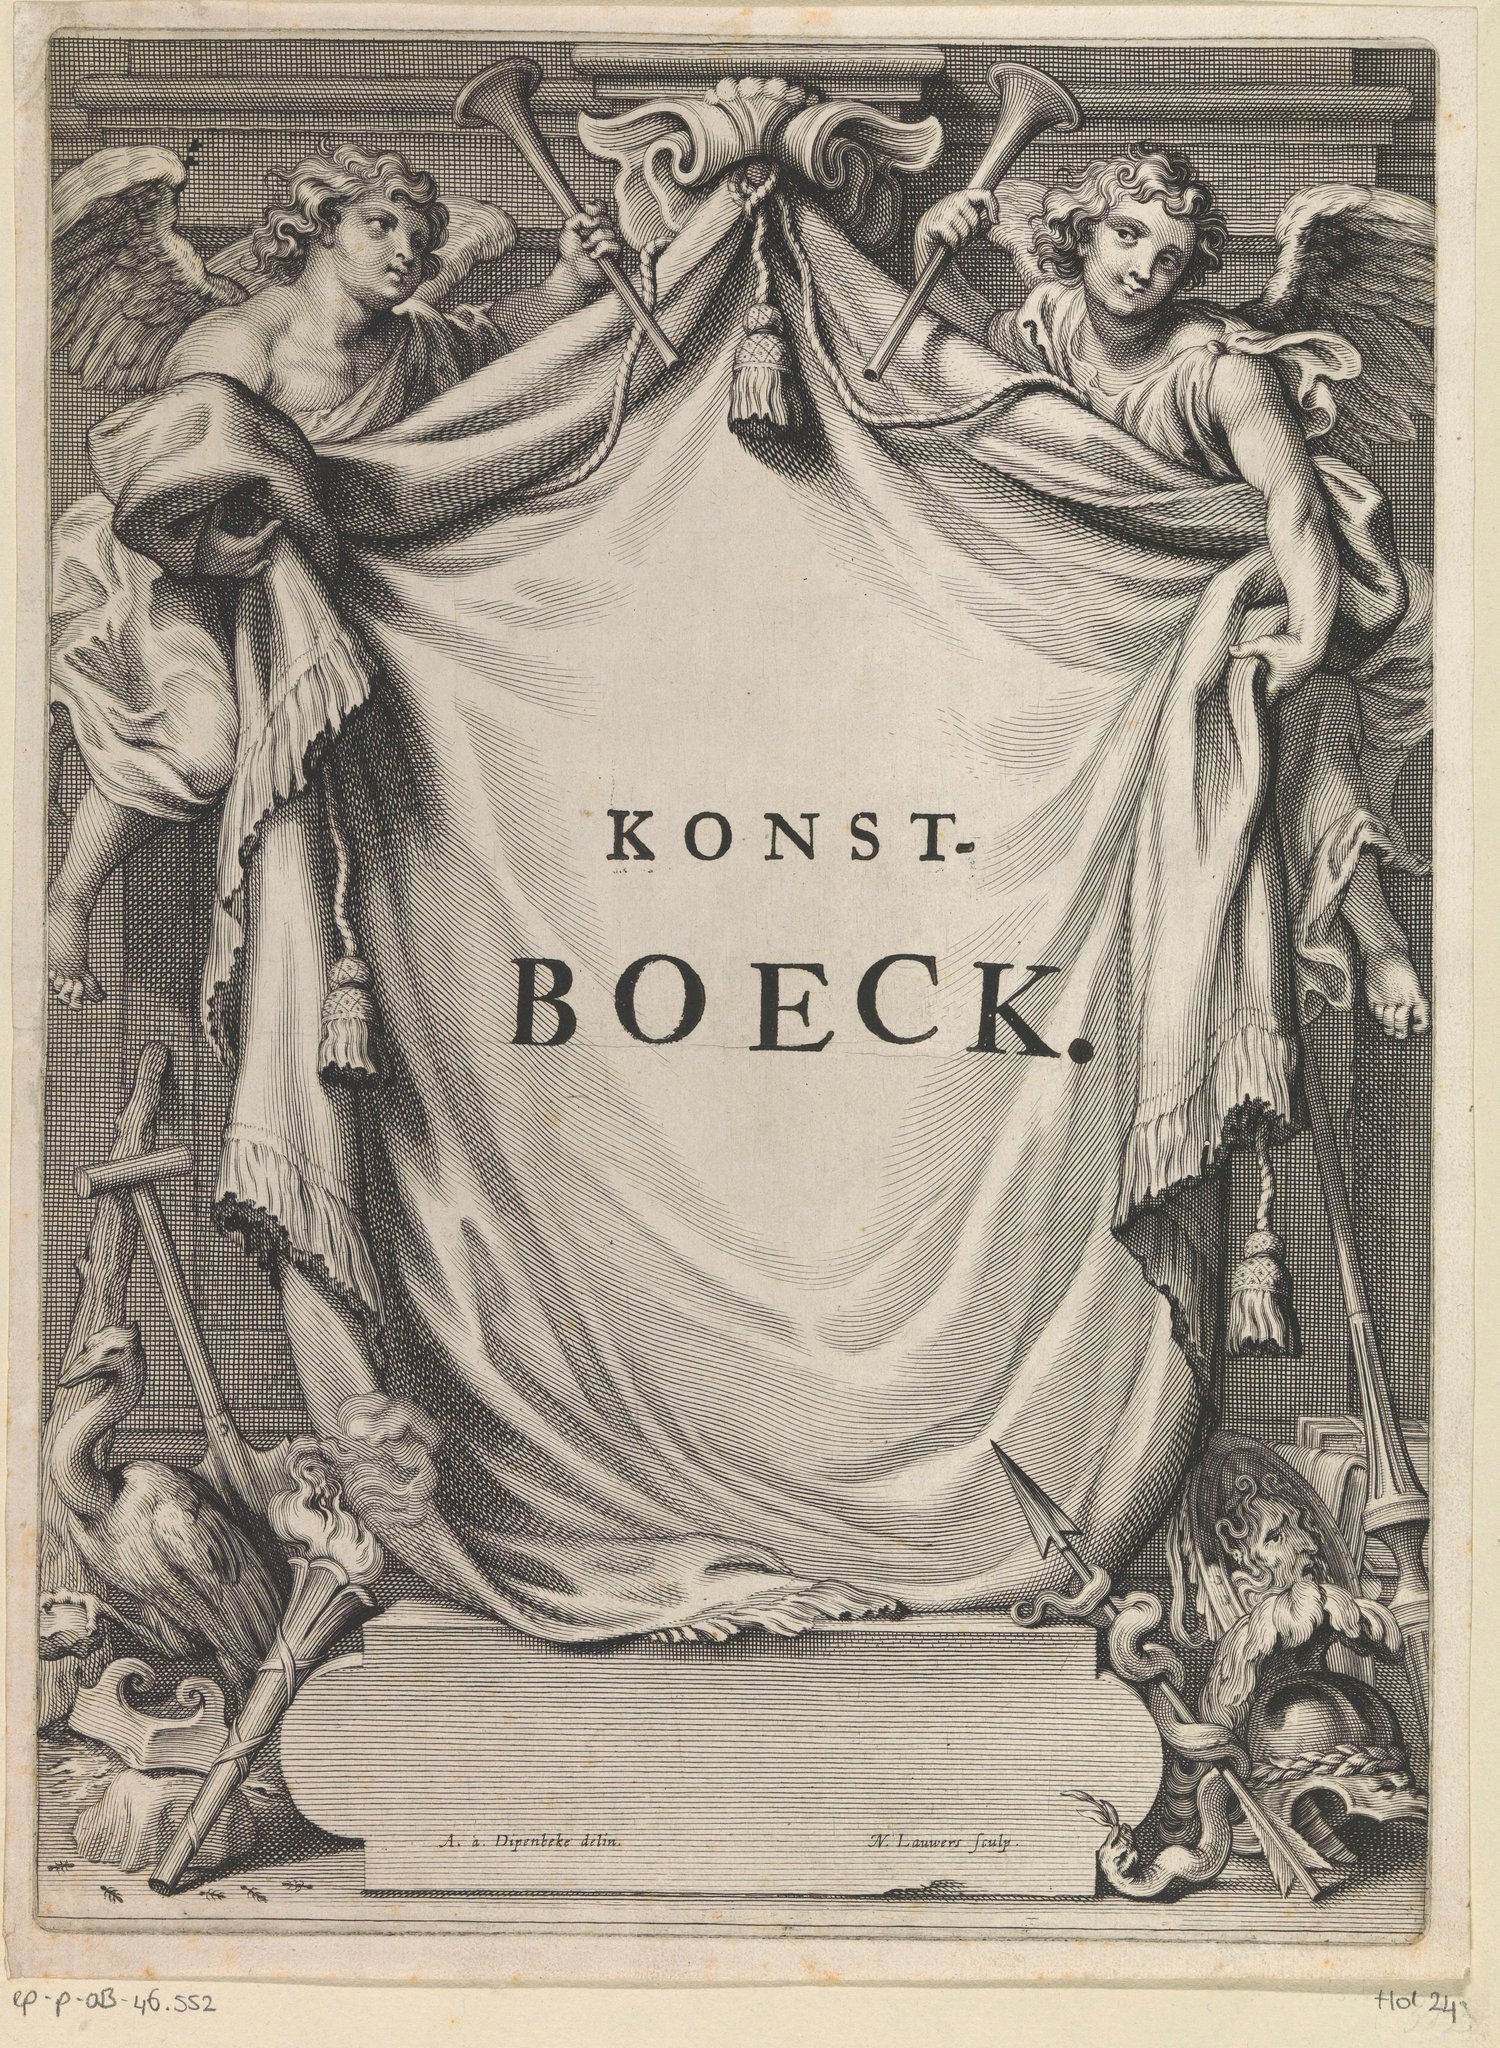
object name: titelprent, frontispice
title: Konst-Boeck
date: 1629-1652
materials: paper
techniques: engraving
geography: antwerp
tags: curtains, fame; 'fama', 'fama buona', 'fama chiara' (ripa)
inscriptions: collector's mark: Lugt 240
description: Titelprent van een tekenboek met negentien platen van Nicolaes Lauwers en Cornelis Galle naar Rubens. Uitgegeven door Jacob de Man te Antwerpen. Dit is een latere staat van de titelprent opgenomen in: Jode, P. de (I). Academiae Graphices - Figurae Picturae Artis Studiosis Utiles (...). Antwerpen, 1629.